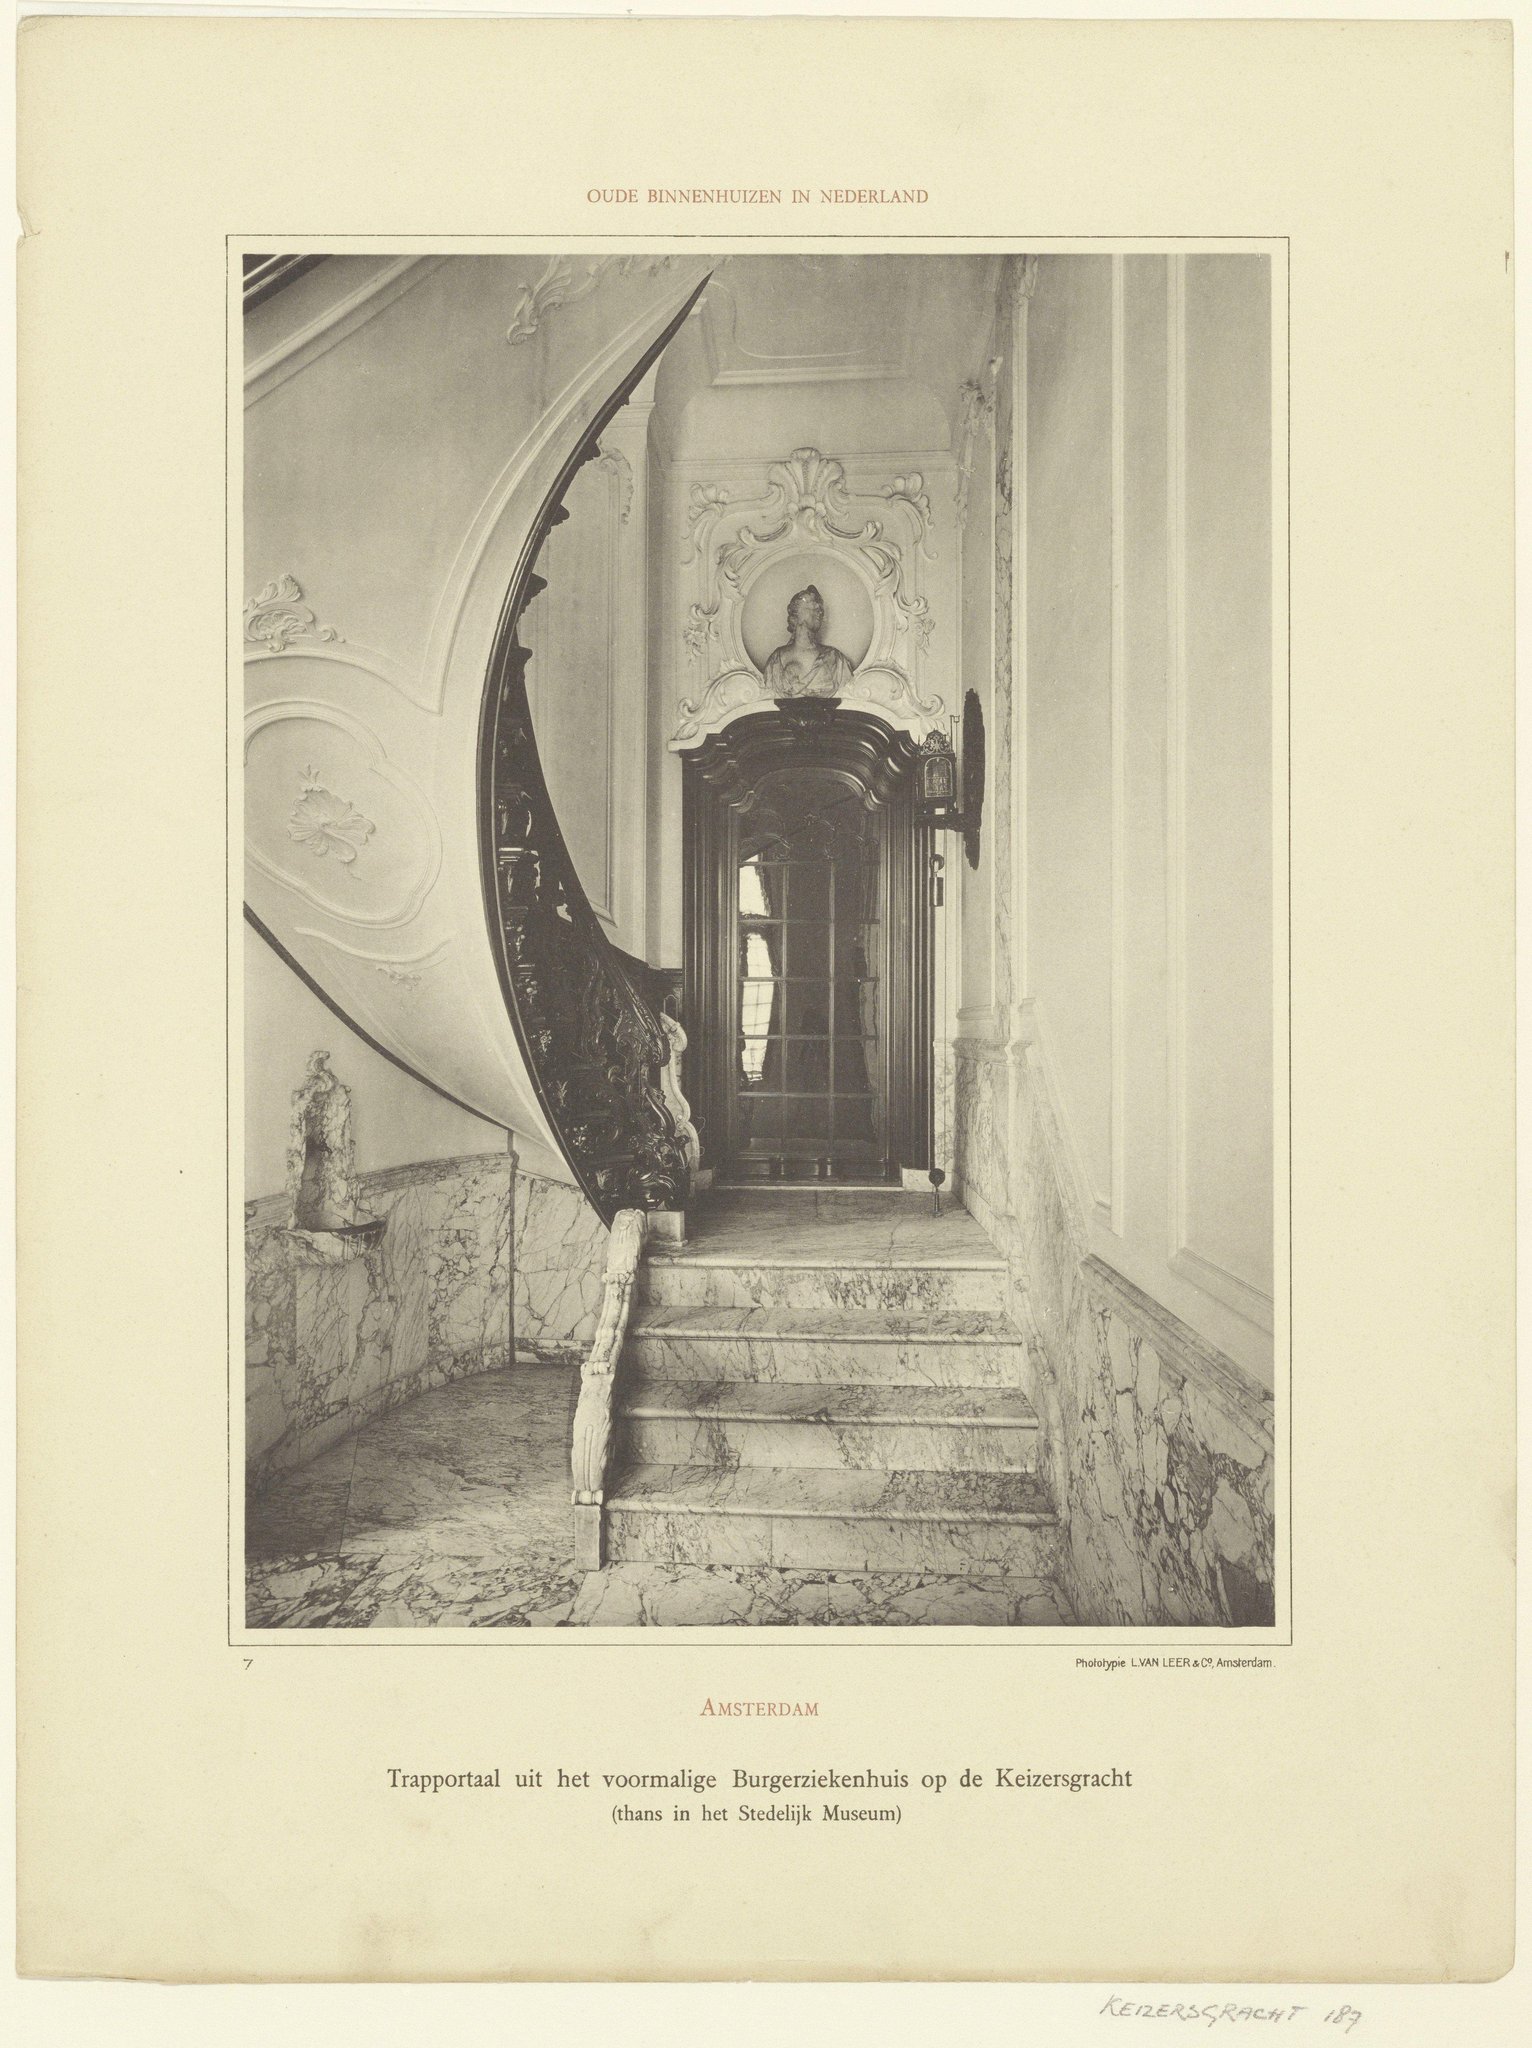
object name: architectural element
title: Onderdelen van het trapportaal uit het pand aan de Keizersgracht 187 te Amsterdam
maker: Anonymous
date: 1740-1760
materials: wood, marble